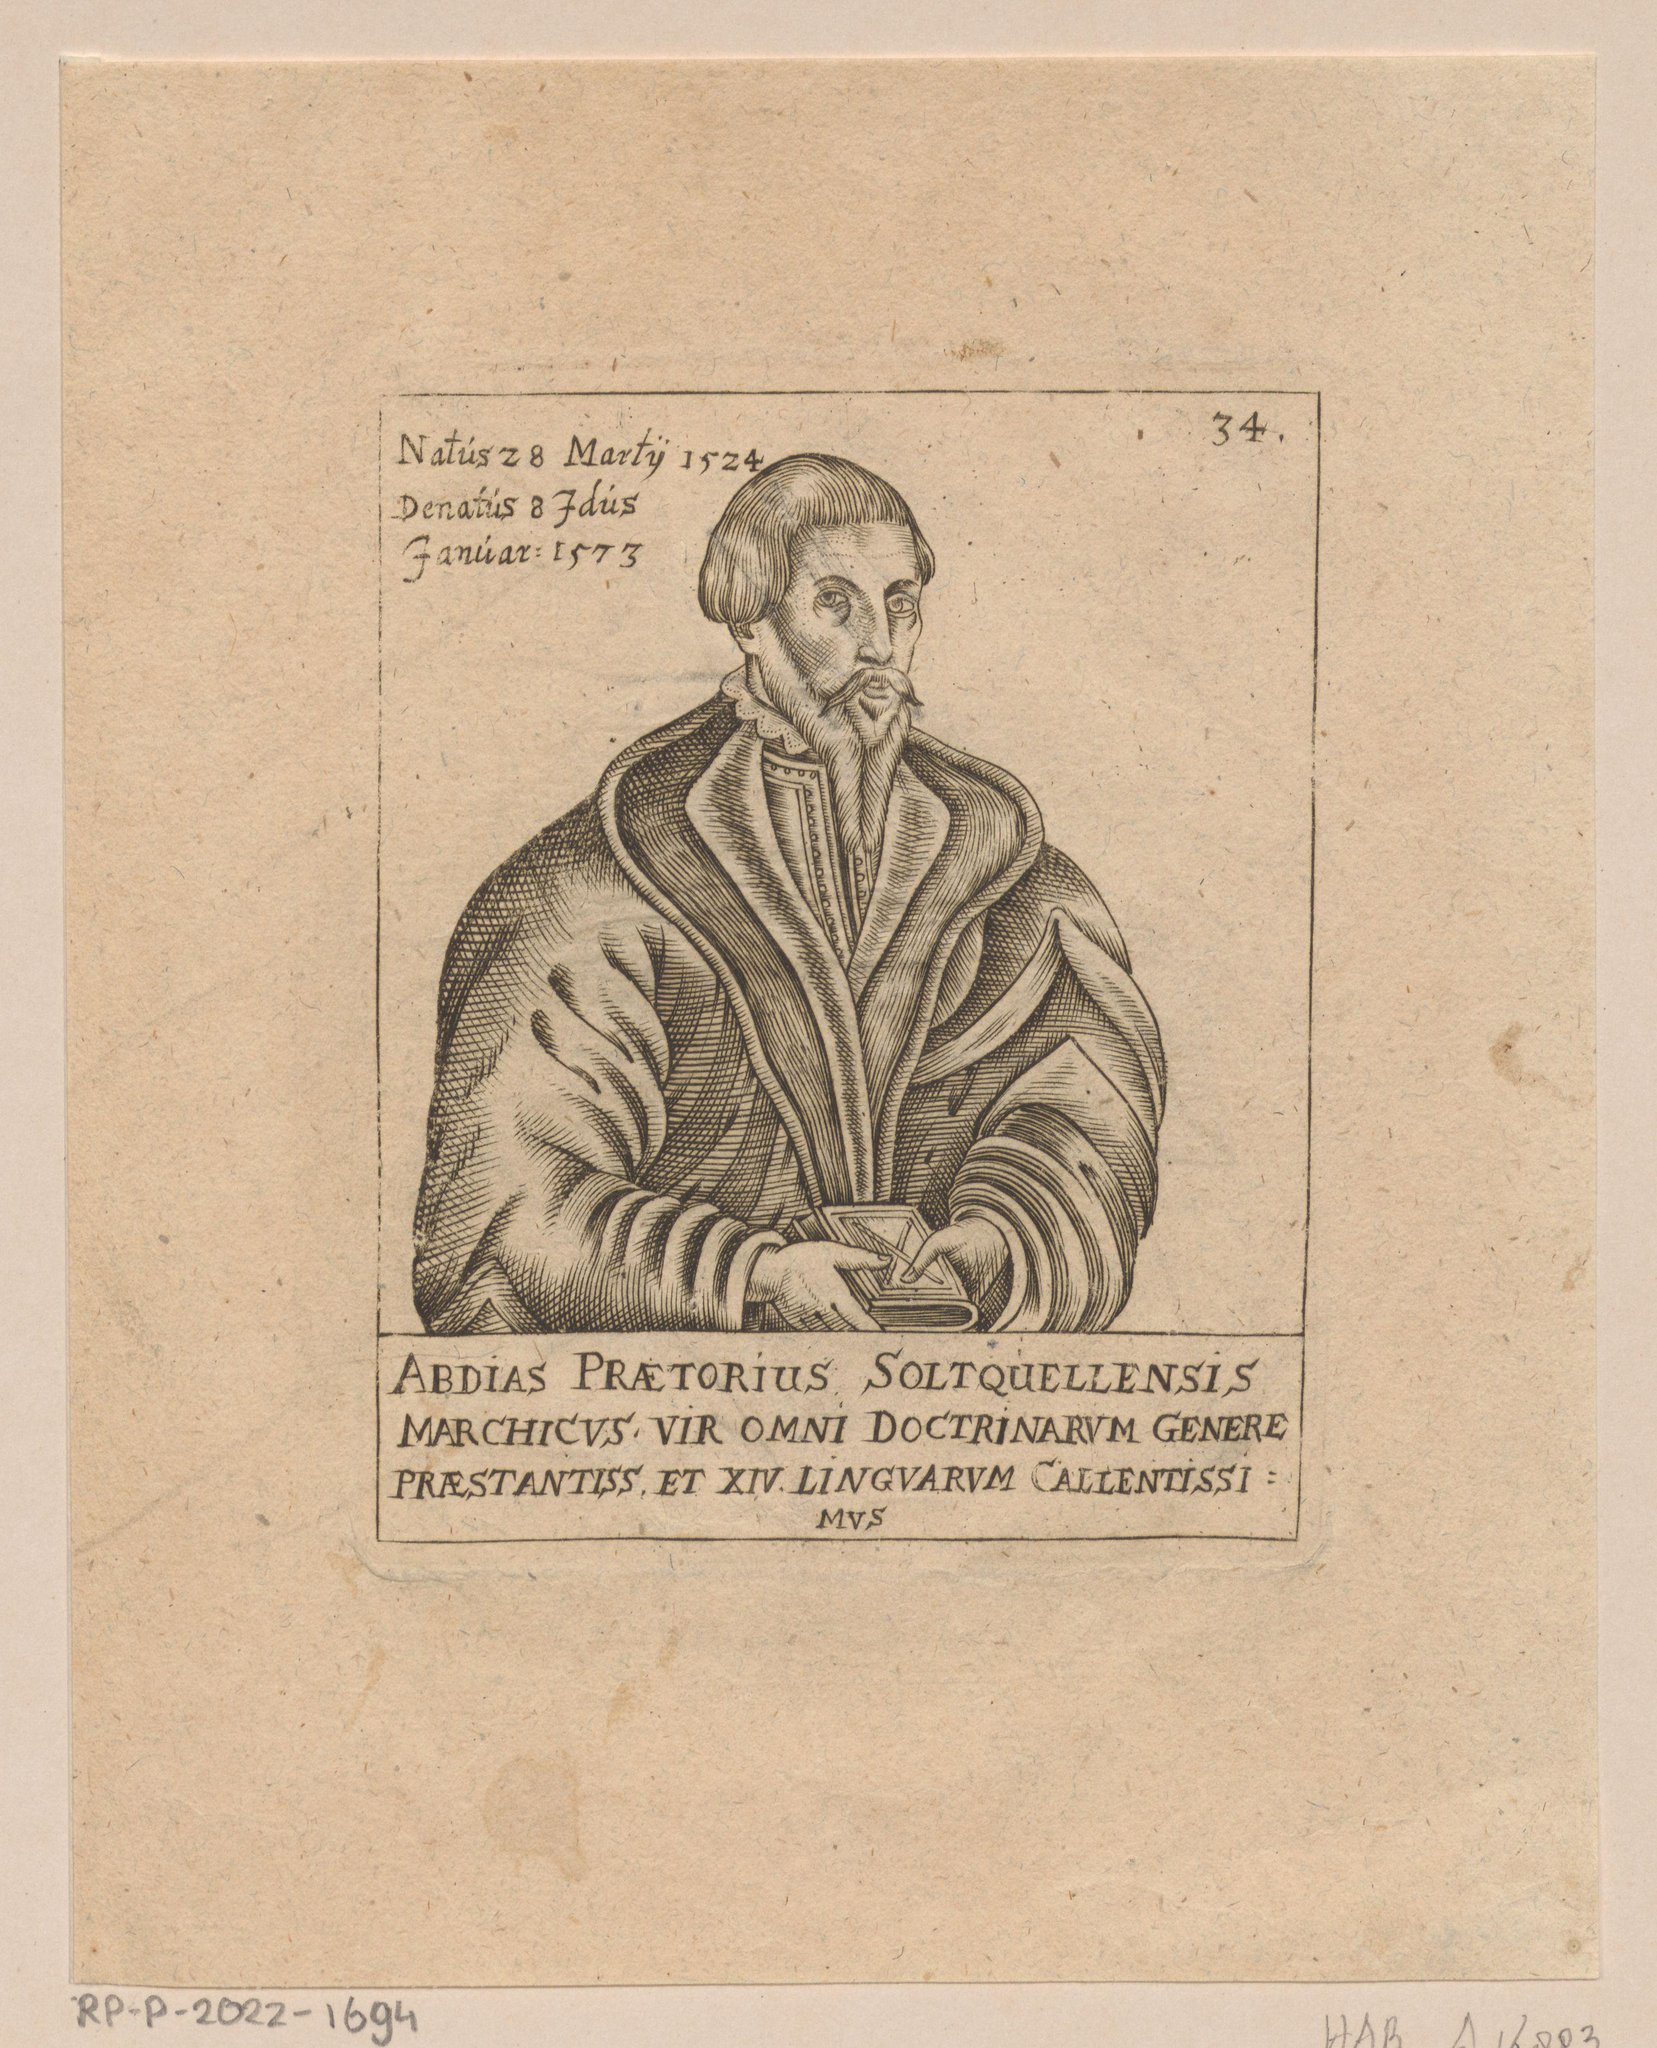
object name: print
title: Illustere mannen verzameld door Martin Friedrich Seidel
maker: Anonymous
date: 1751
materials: paper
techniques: engraving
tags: theologian, historical persons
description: De prent is uitgegeven als onderdeel van een serie. Later is de prent mogelijk ook als boekillustratie gebruikt in: Küster, Georg Gottfried. Martin Friedrich Seidels Bilder-Sammlung in welcher hundert, gröstentheils in der Mark Brandenburg (…). Berlijn: Buchladen bey der Real-Schule, 1751. Het is onduidelijk tot welke uitgave de huidige prent behoort.